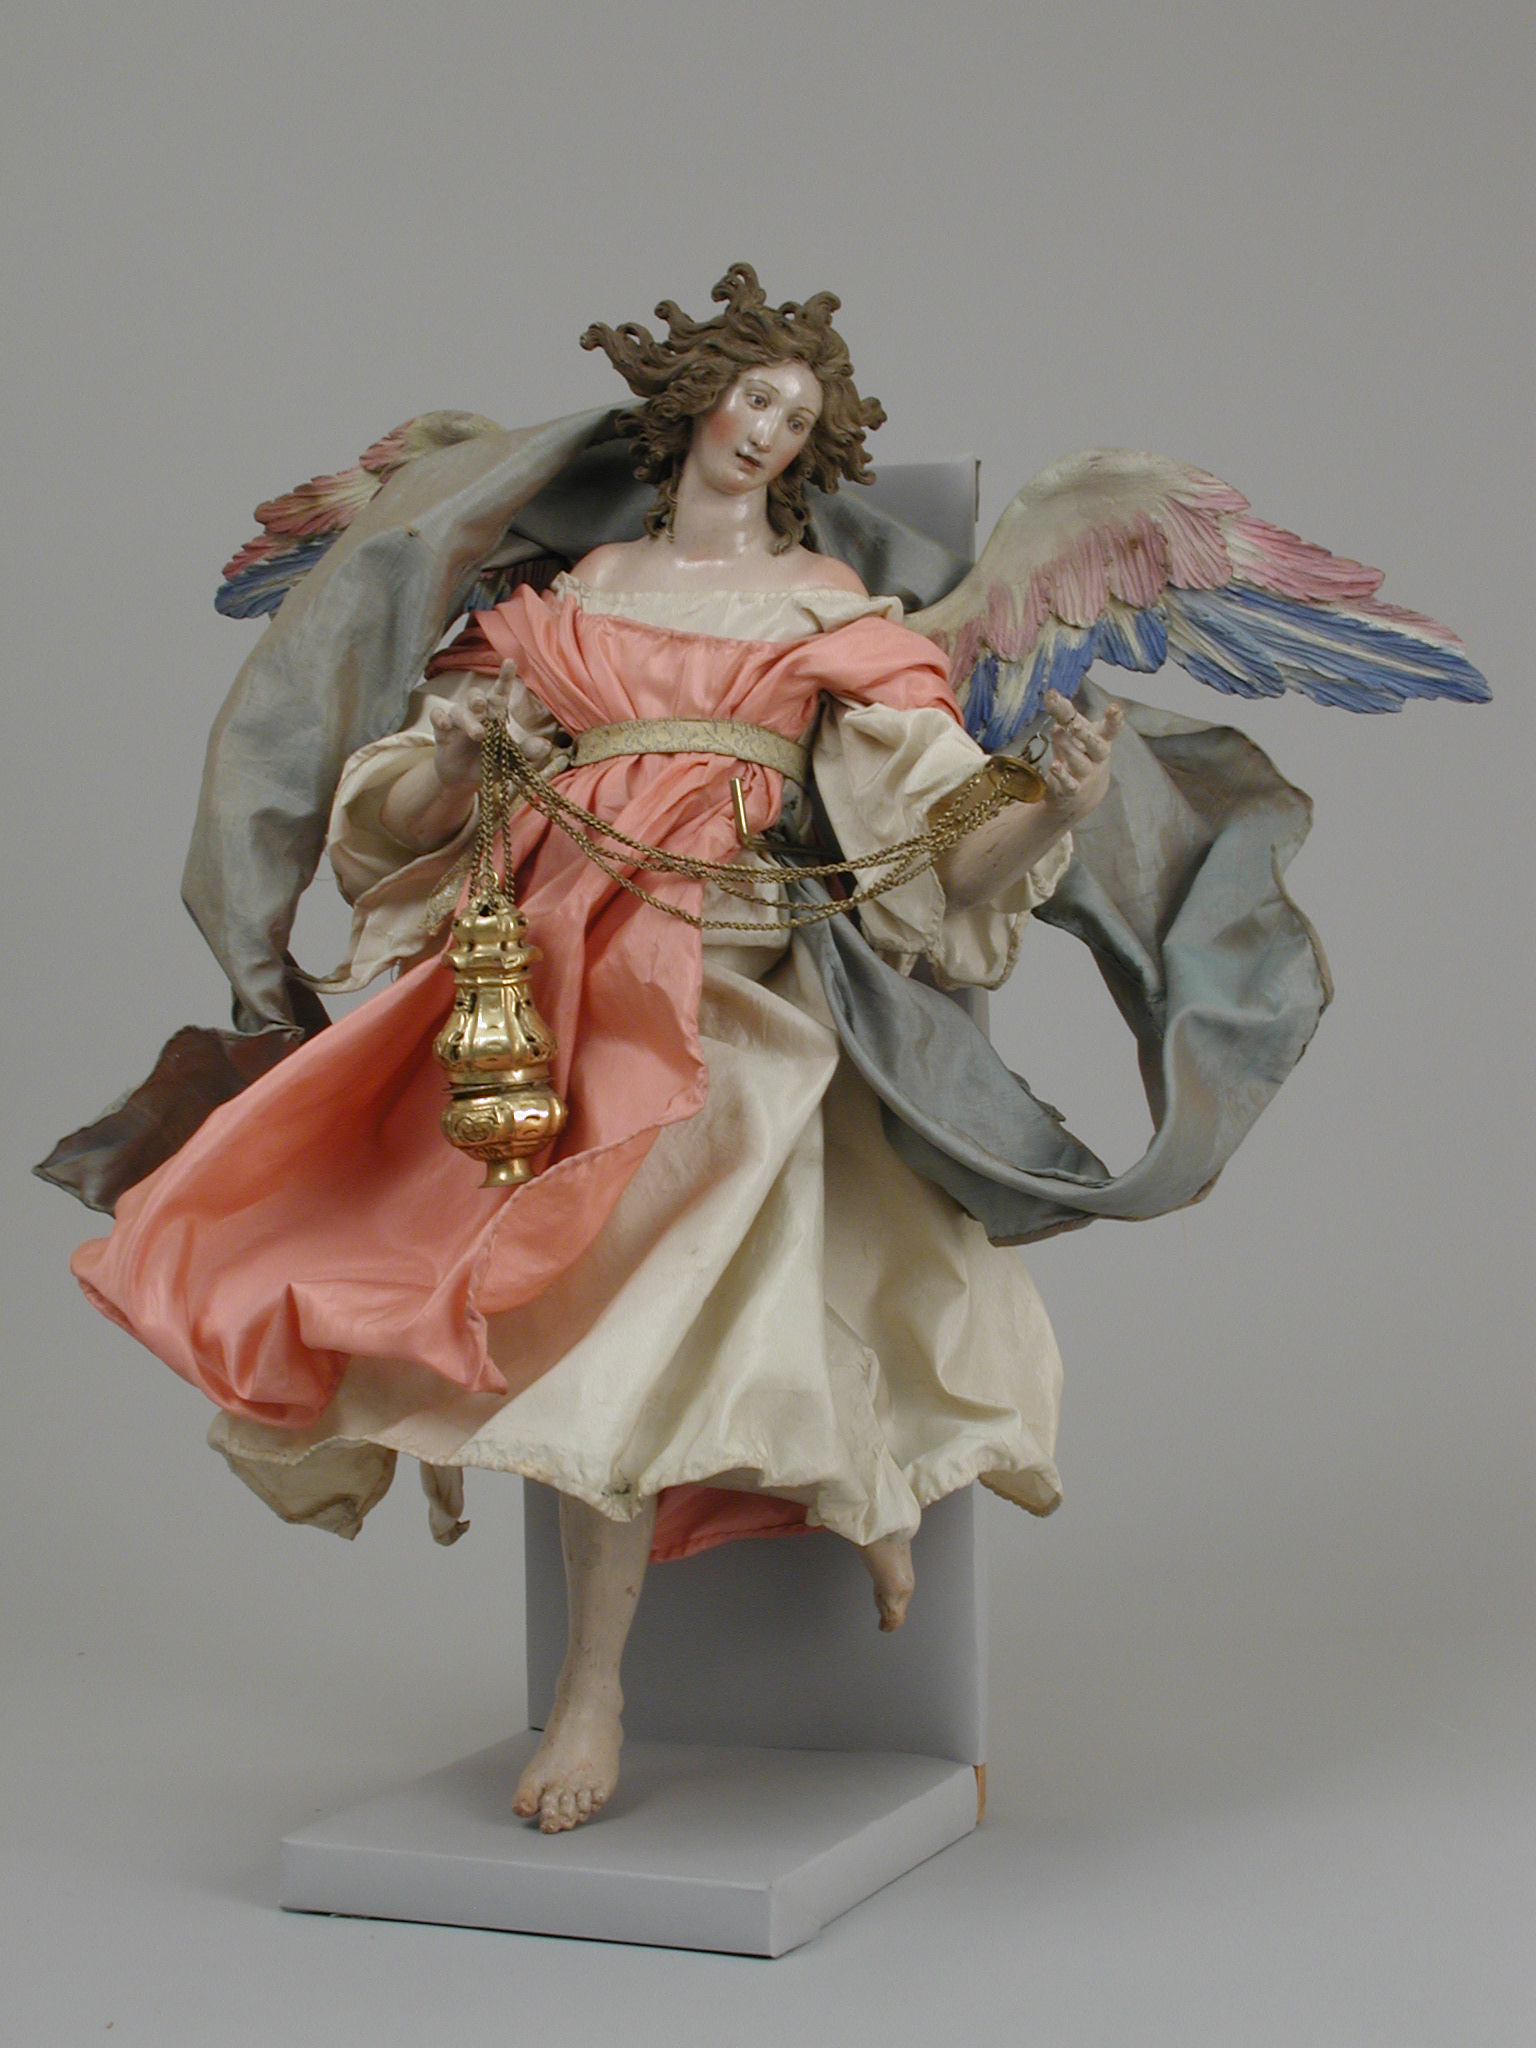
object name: crèche figure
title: Angel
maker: salvatore di franco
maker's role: maker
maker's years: 1700-1799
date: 1751-1800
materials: silk, silver gilt, terracotta, fiber, metal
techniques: polychrome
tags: angels